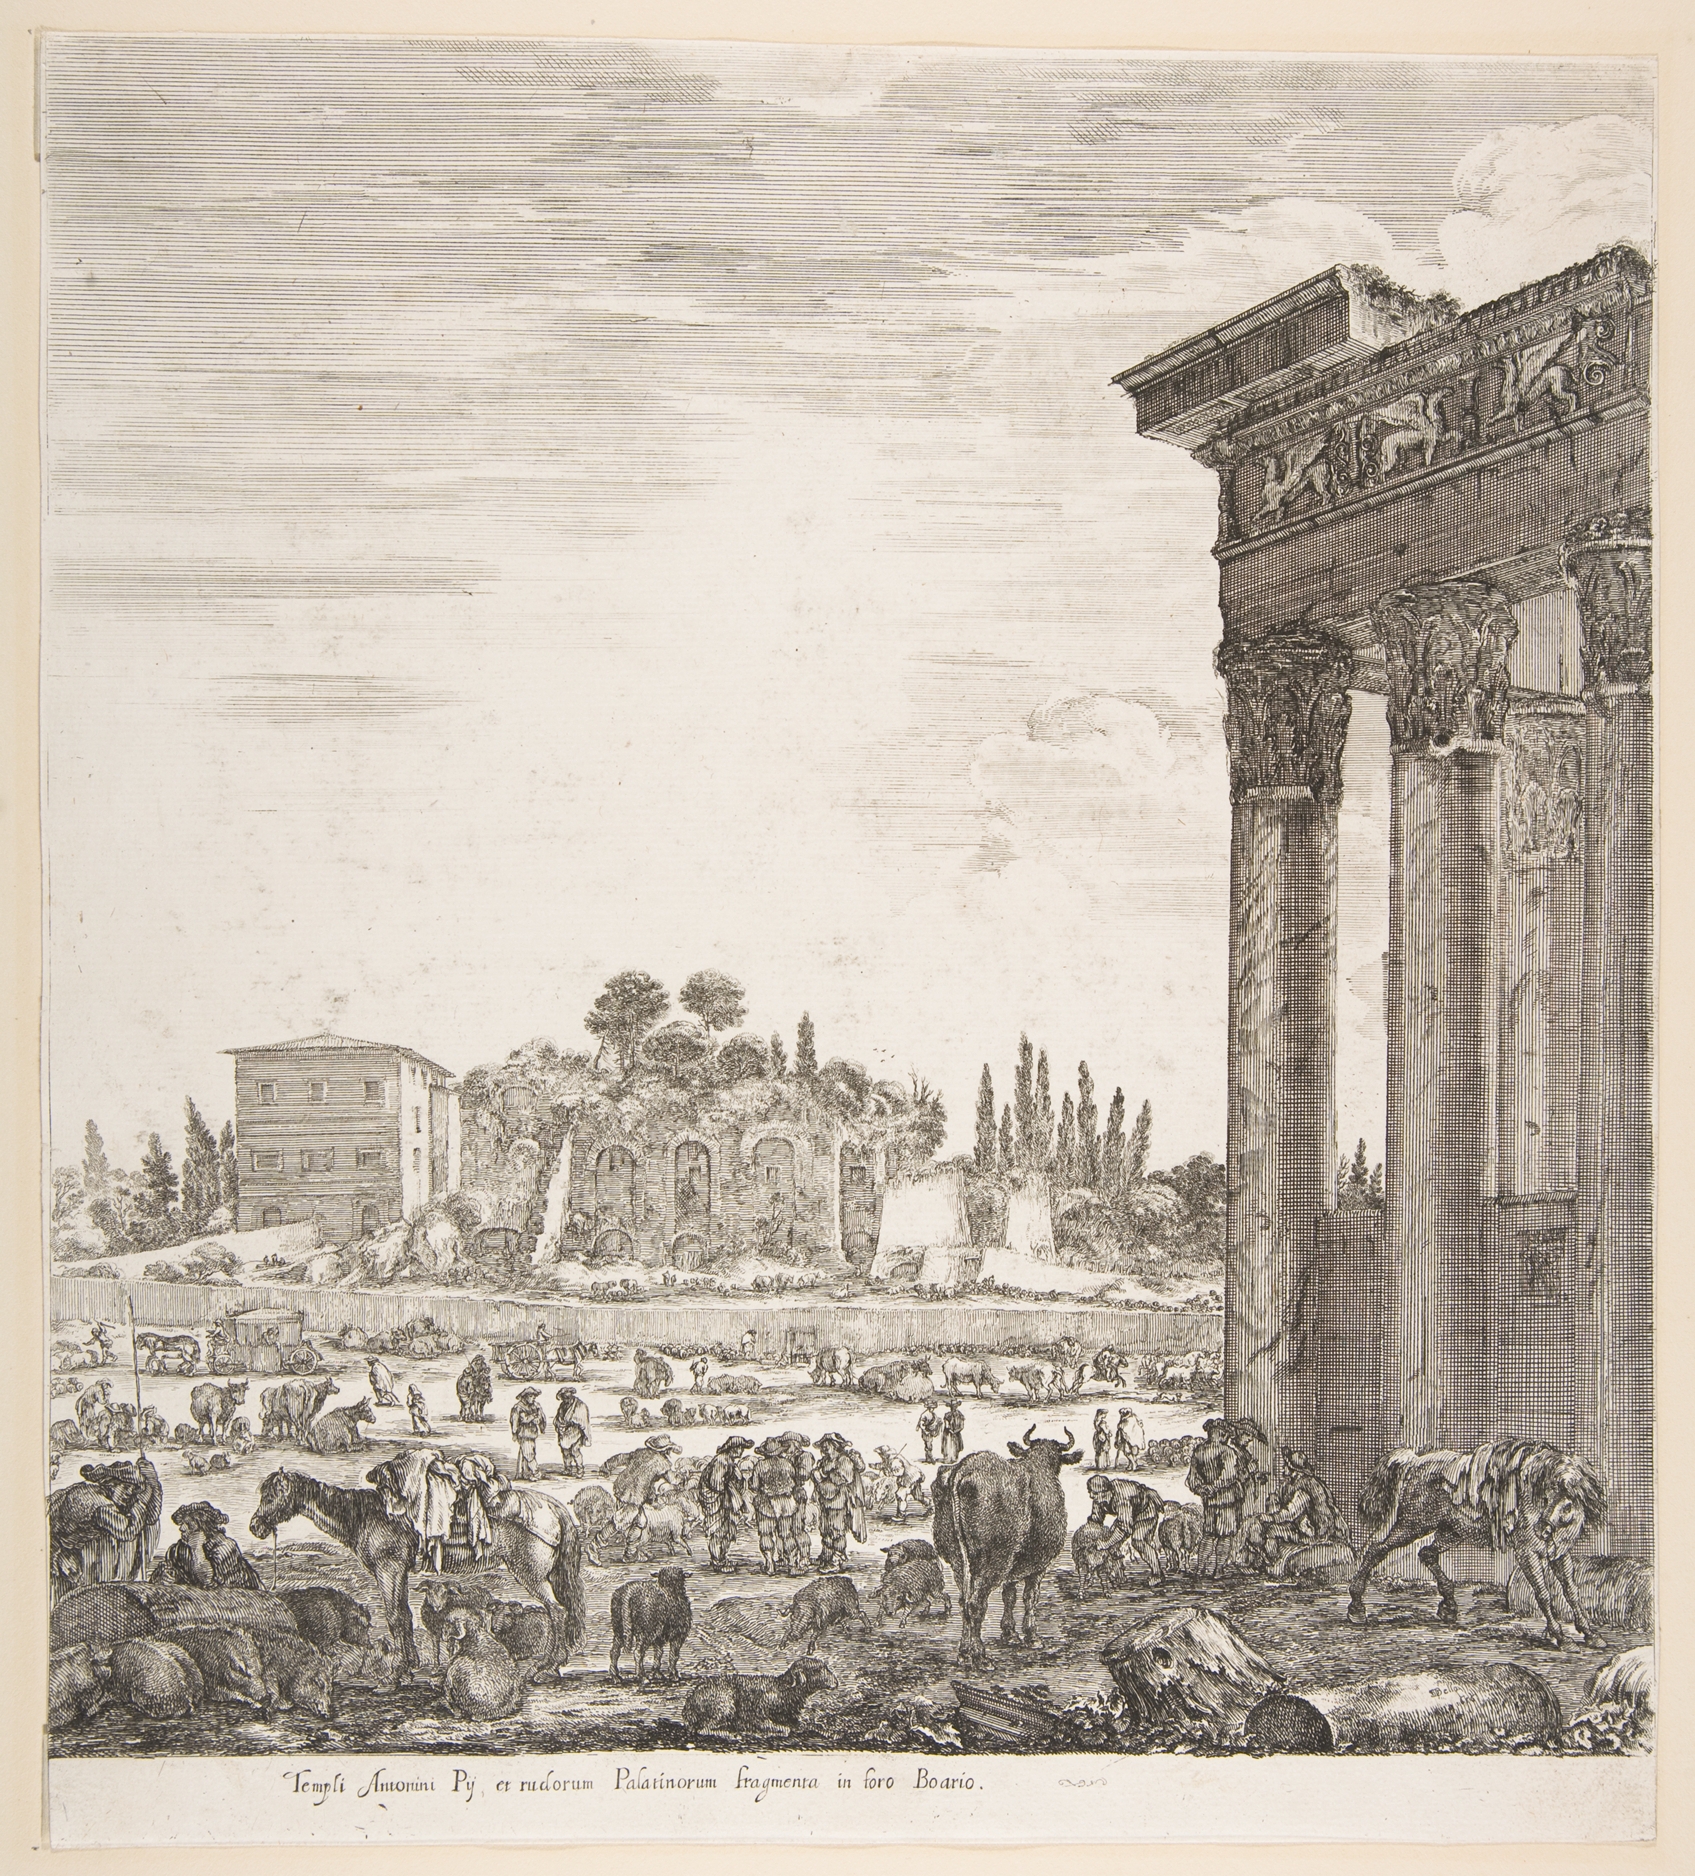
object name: print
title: The columns of the Temple of Antoninus to right, a part of the Campo Vaccino in center and at left, along with various animals and figures, the Palatine ruins in the background, from "Six large views, four of Rome, and two of the Roman countryside" (Six grandes vues, dont quatre de Rome et deux de la Campagne romaine)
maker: stefano della bella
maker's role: artist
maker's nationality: italian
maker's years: 1610-1664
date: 1656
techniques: etching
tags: columns,ruins,cows,horses,rome